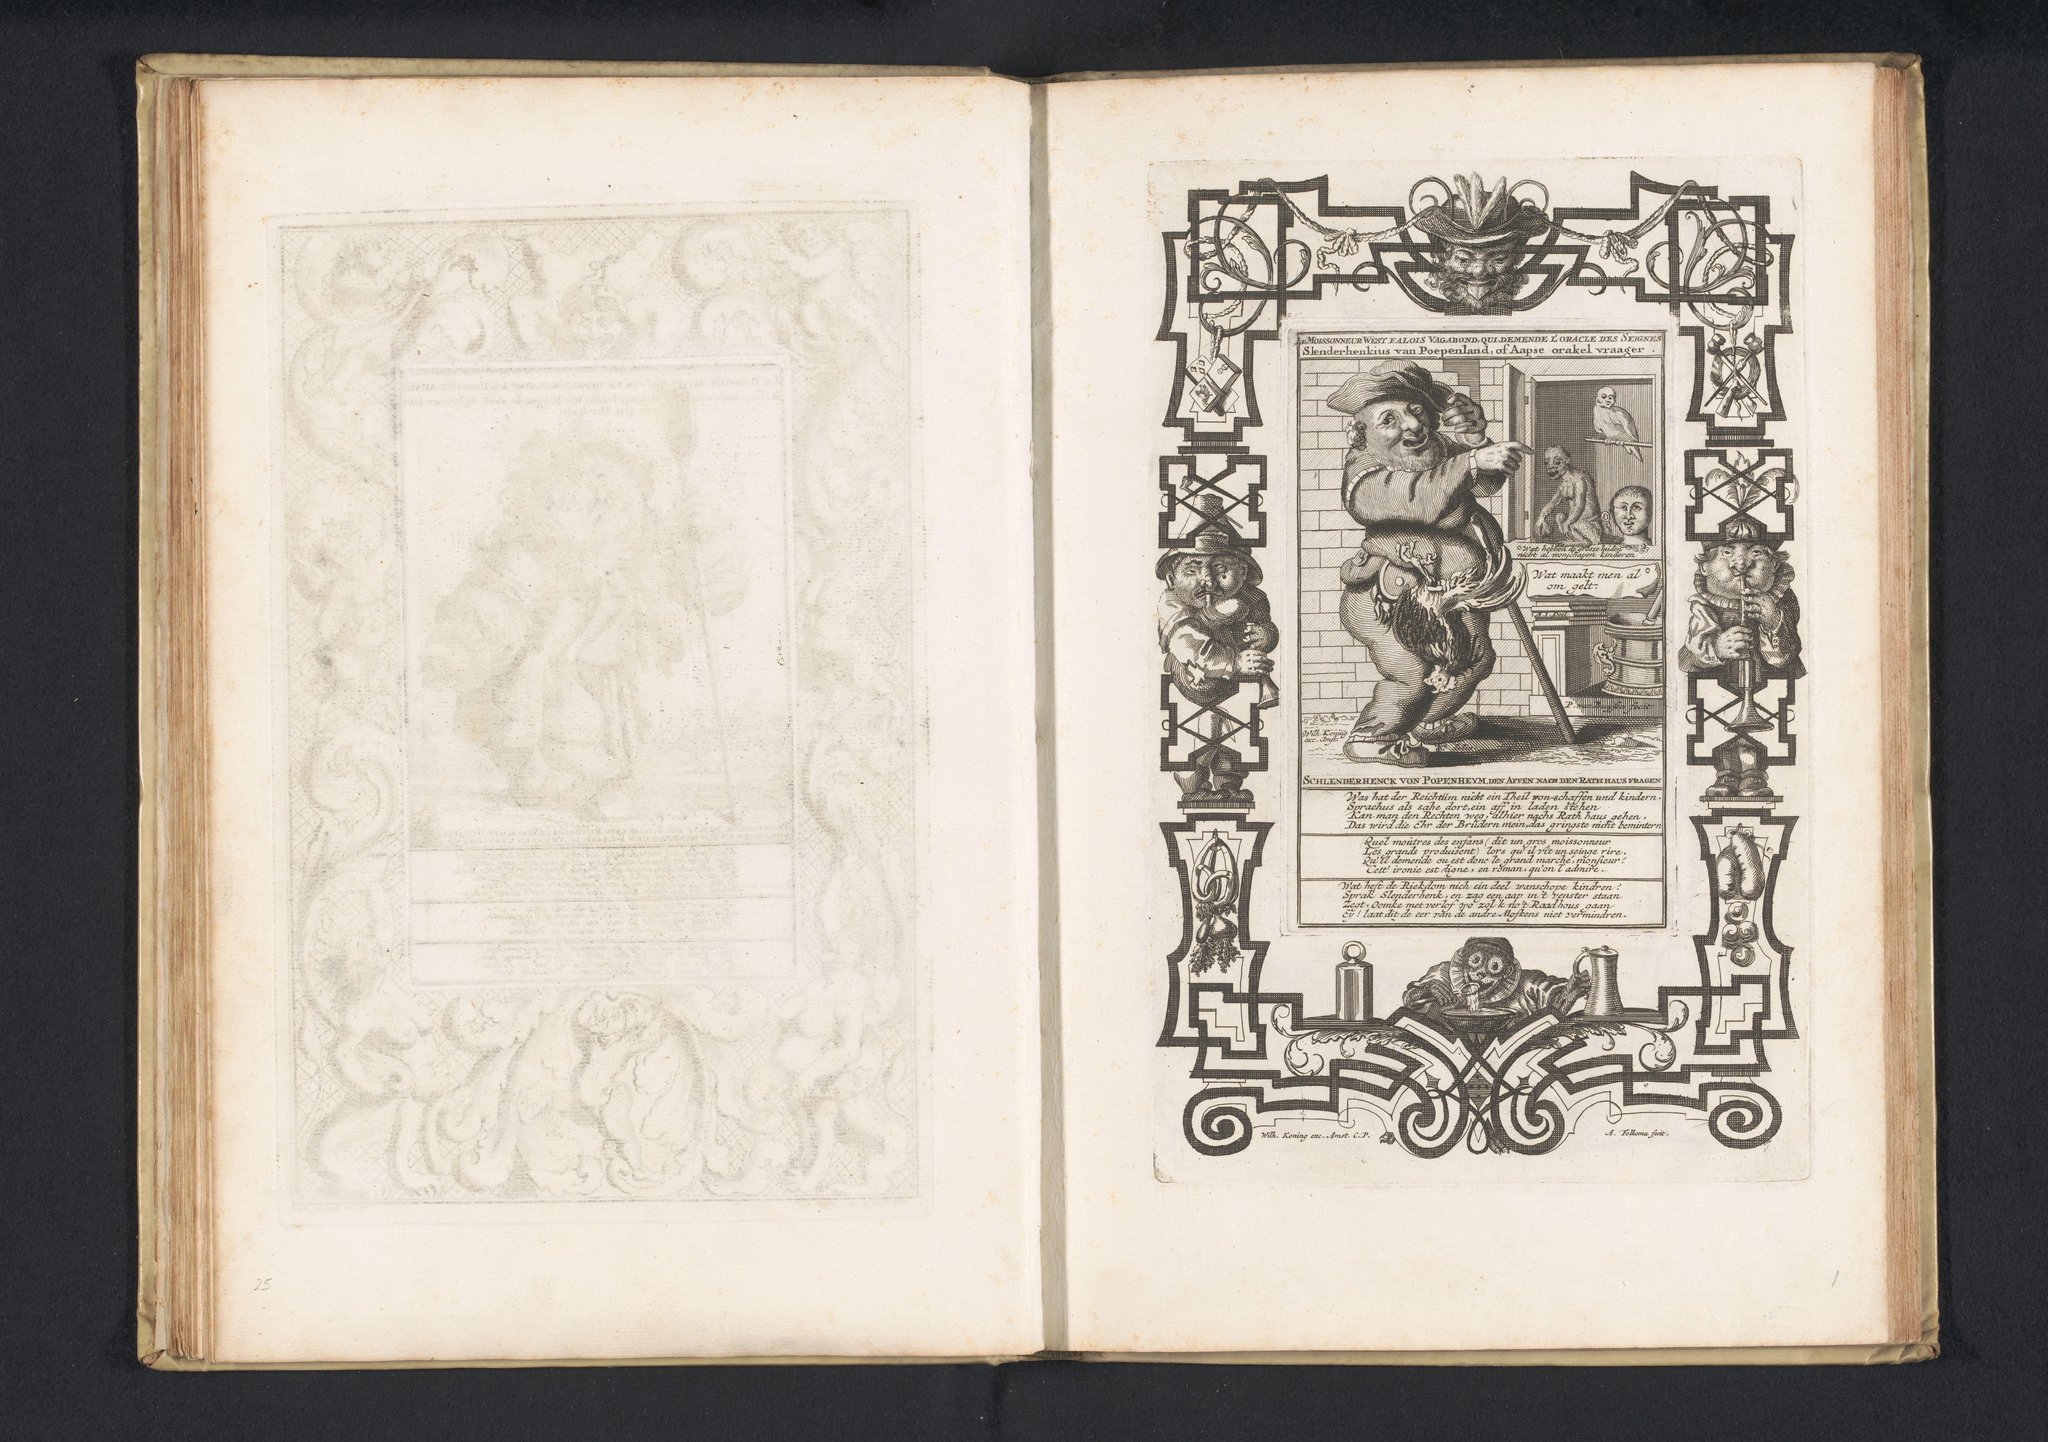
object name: print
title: De kleine mens Slenderhenkius van Poepenland, 1720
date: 1718-1720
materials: paper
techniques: etching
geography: northern netherlands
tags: caricatures (human types), little people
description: De kleine mens Slenderhenkius van Poepenland vraagt de aap om raad. In het onderschrift verzen in het Duits, Frans en Nederlands. Ongenummerd (A 1 Deel). Afdruk binnen een decoratieve omlijsting gedrukt van een aparte plaat met muziekmakende kleine mensen met onderaan een aap die pap eet. Onderdeel van de tweede Nederlandse gebonden uitgave uit 1720 (en gerelateerd aan de Windhandel in dat jaar) van een serie karikaturen van kleine mensen, bekend als Het Dwergentooneel, deels gekopieerd naar een ouder Duits voorbeeld.